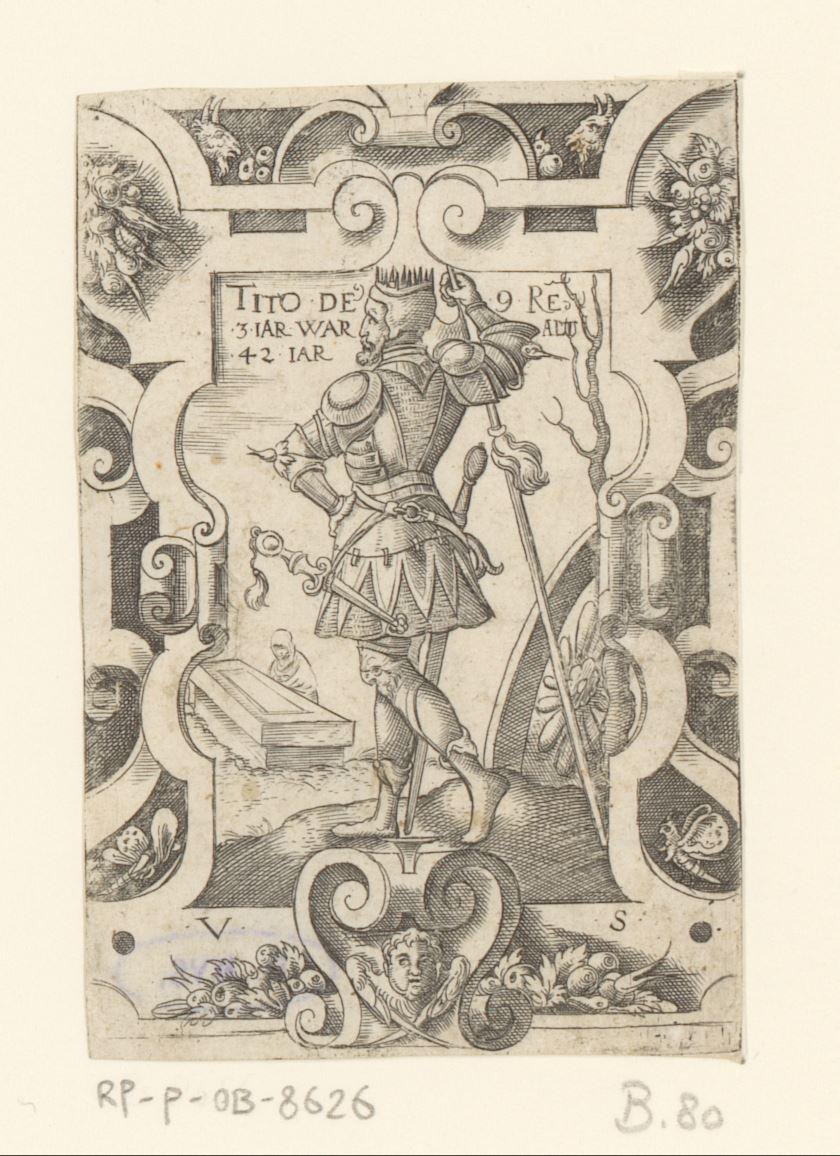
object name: print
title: Keizer Titus in rolwerk omlijsting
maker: virgilius solis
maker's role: draughtsman, print maker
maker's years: 1514-1562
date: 1524-1562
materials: paper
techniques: engraving, etching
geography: nuremberg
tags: rome, (story of) the emperor titus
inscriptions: number: ‘125’, collector's mark: Lugt 2228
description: Deze prent maakt deel uit van een serie bestaande uit twaalf prenten met de eerste Romeinse keizers staand in rolwerk omlijstingen. In de collectie van het Rijksmuseum bevinden zich elf van de twaalf prenten.